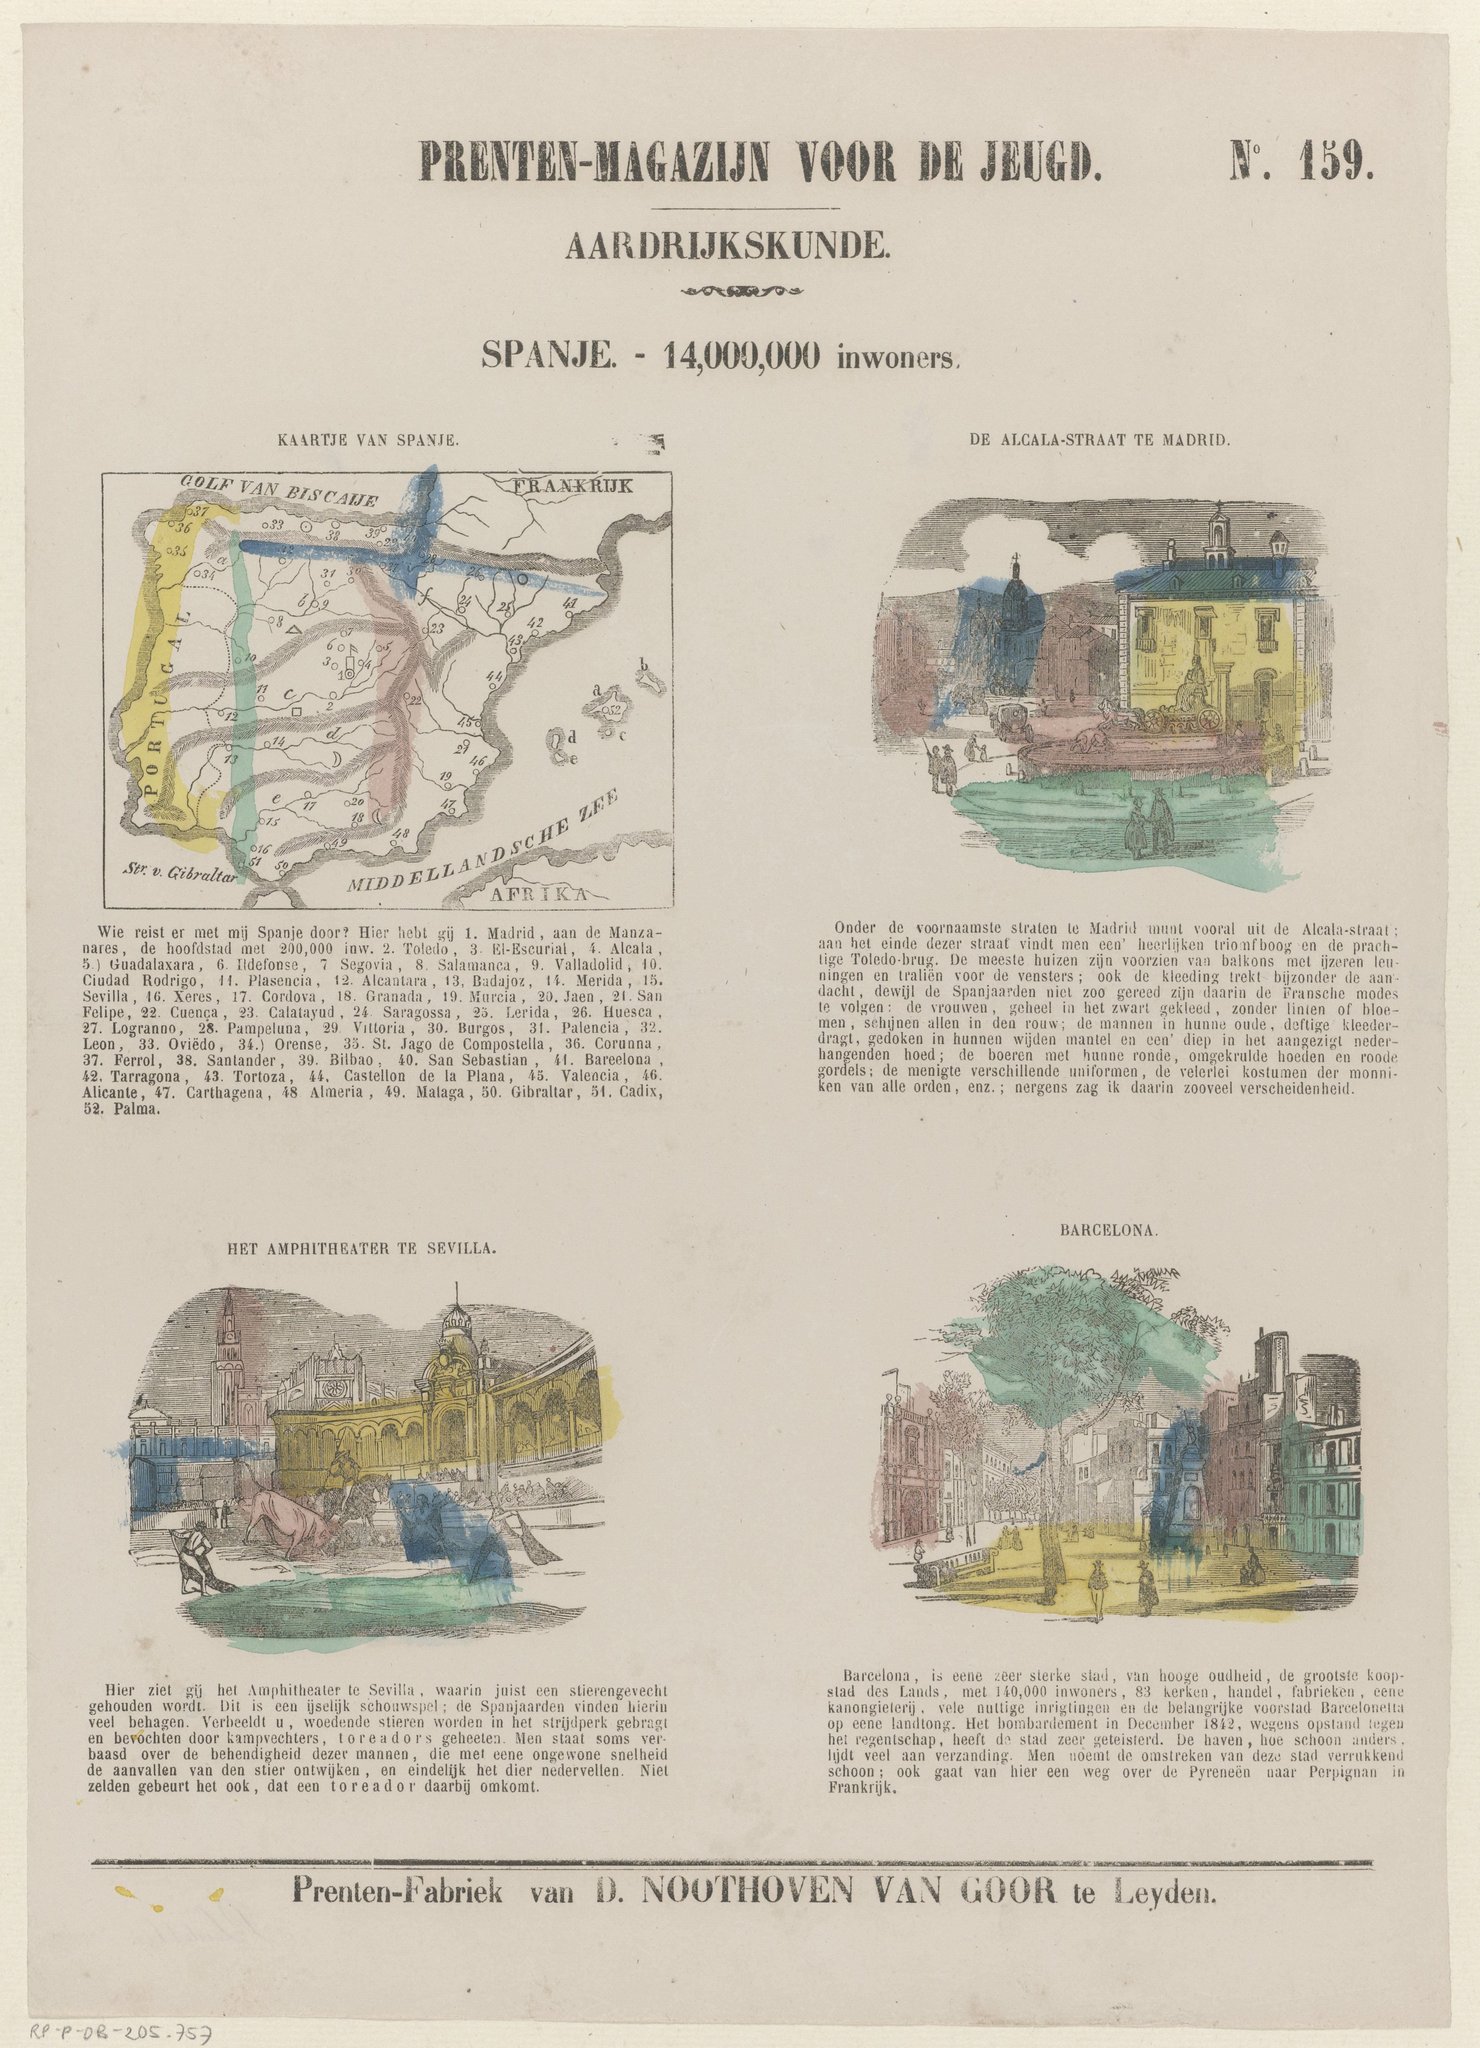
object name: print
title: Spanje. - 14,000,000 inwoners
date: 1850-1881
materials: paper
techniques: colour, letterpress printing, engraving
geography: netherlands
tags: buildings for performances, maps, atlases, sevilla, spain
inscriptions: inscription: ‘P Leidekker’, collector's mark: Lugt 2760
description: Blad met 4 voorstellingen over Spanje met een kaart en belangrijke steden en monumenten: Madrid, het Amfitheater in Sevilla en Barcelona. Boven elke voorstelling een titel en onder elke voorstelling een onderschrift. Genummerd rechtsboven: No. 159.